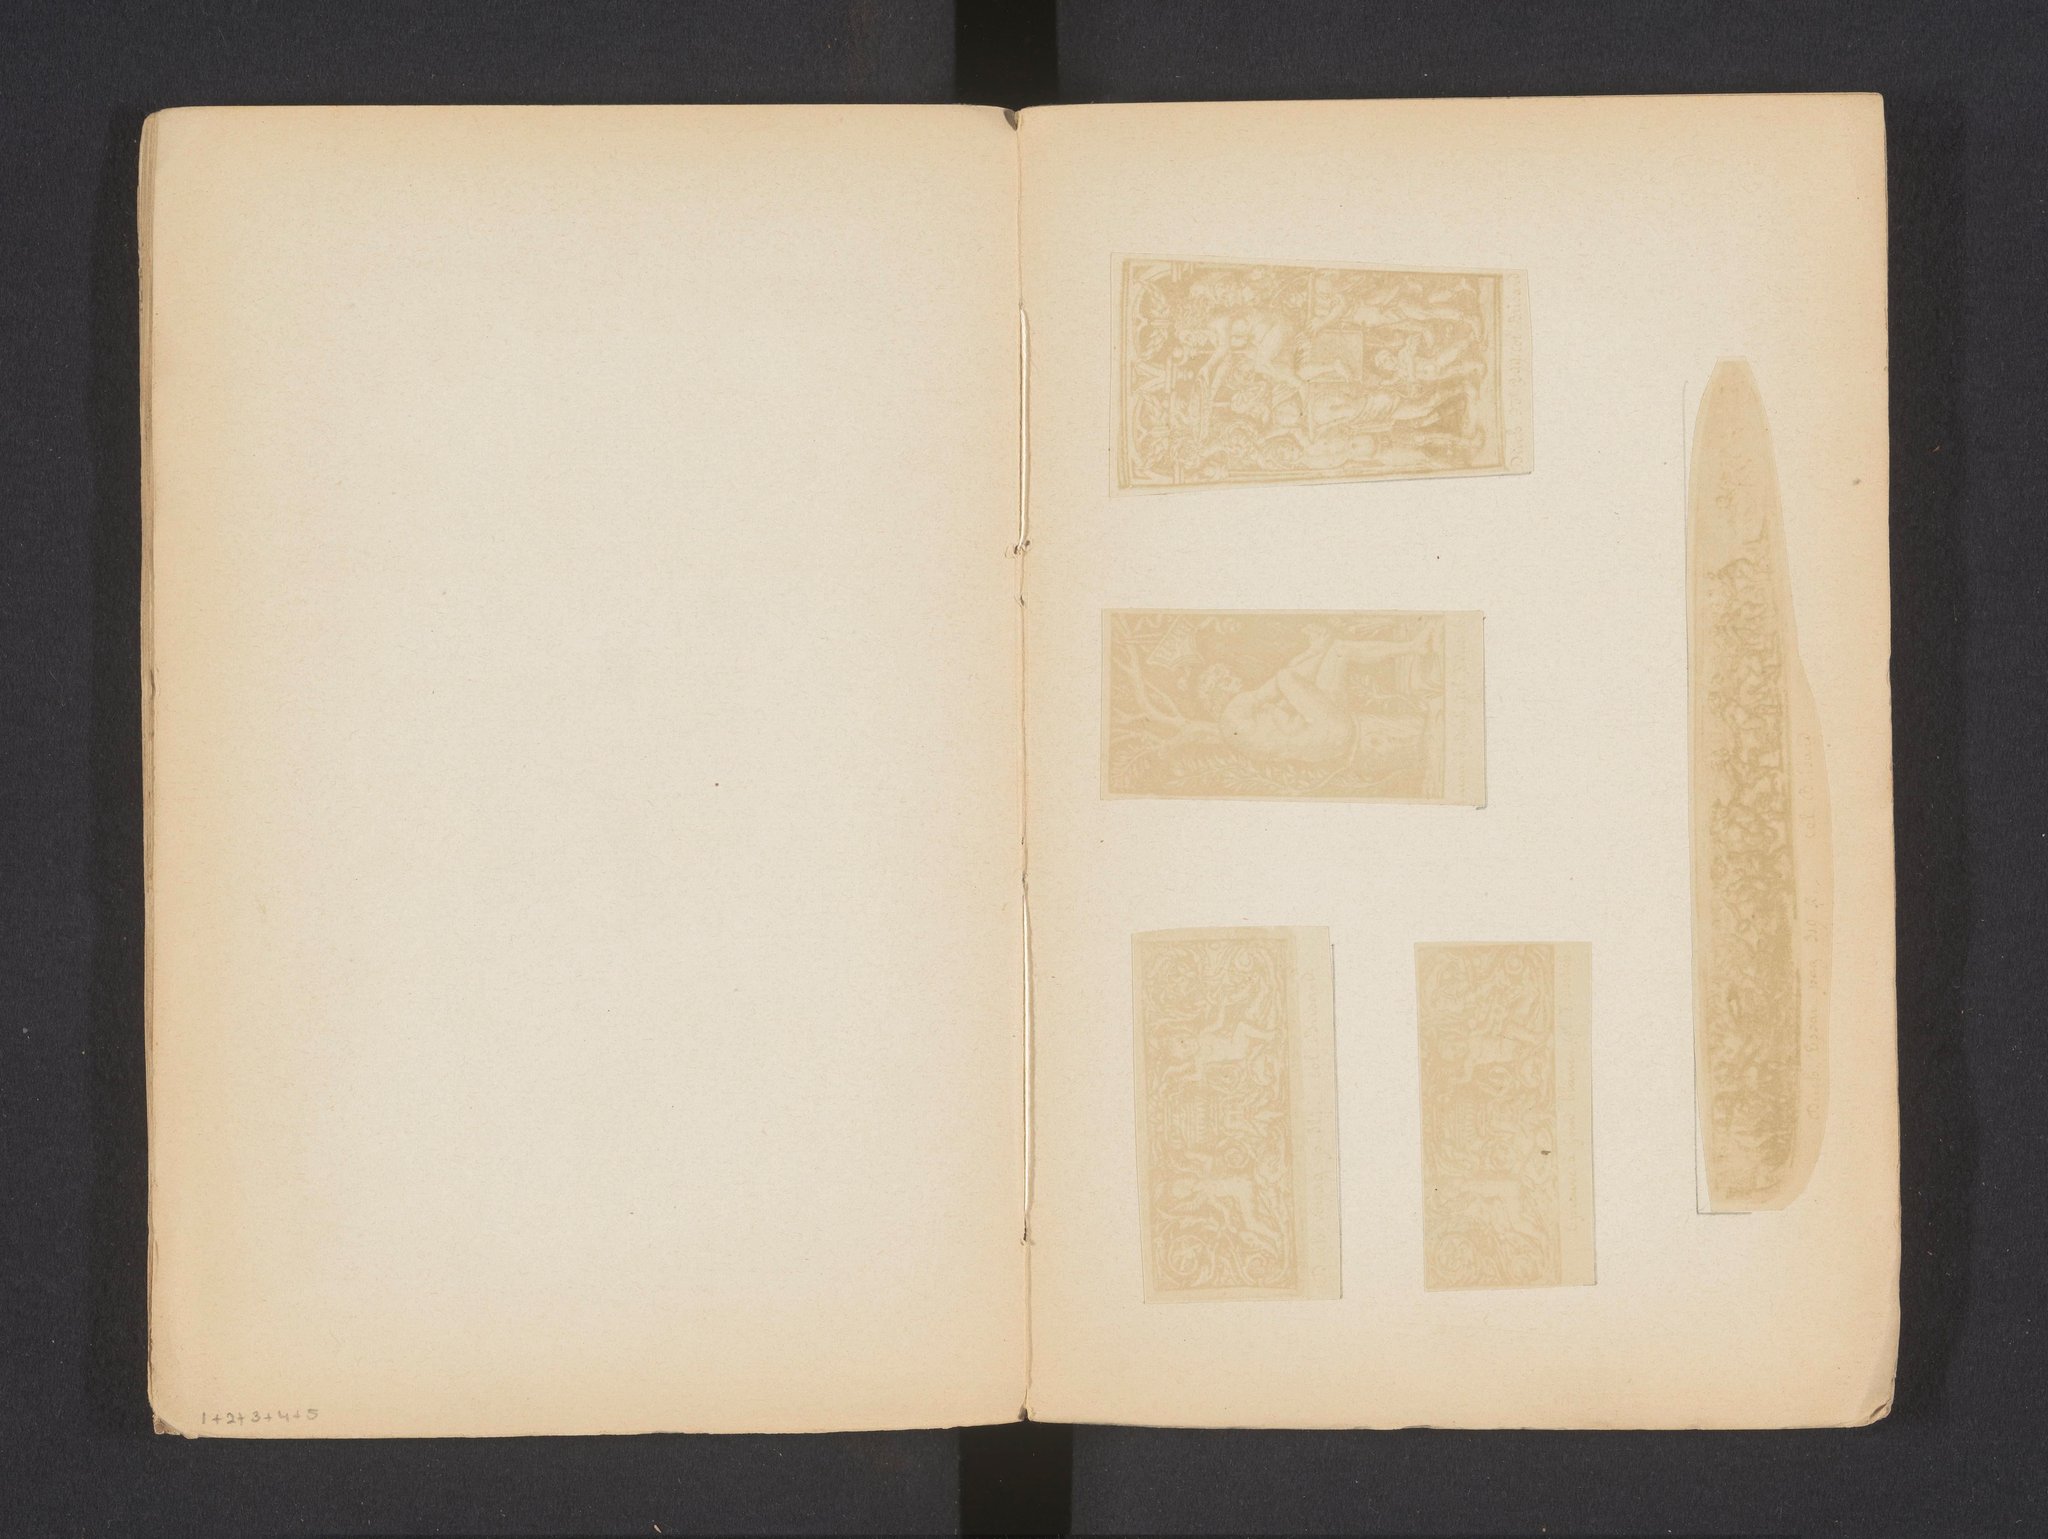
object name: photograph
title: Fotoreproductie van een prent van een allegorie met een oude vrouw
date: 1853-1858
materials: photographic support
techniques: salted paper print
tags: old woman, symbolic representations, allegories and emblems ~ drawing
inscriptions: inscription: ‘Duch. No. 299. col. [.}. Brisard’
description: Foto op derde ongenummerde pagina na pagina 142.